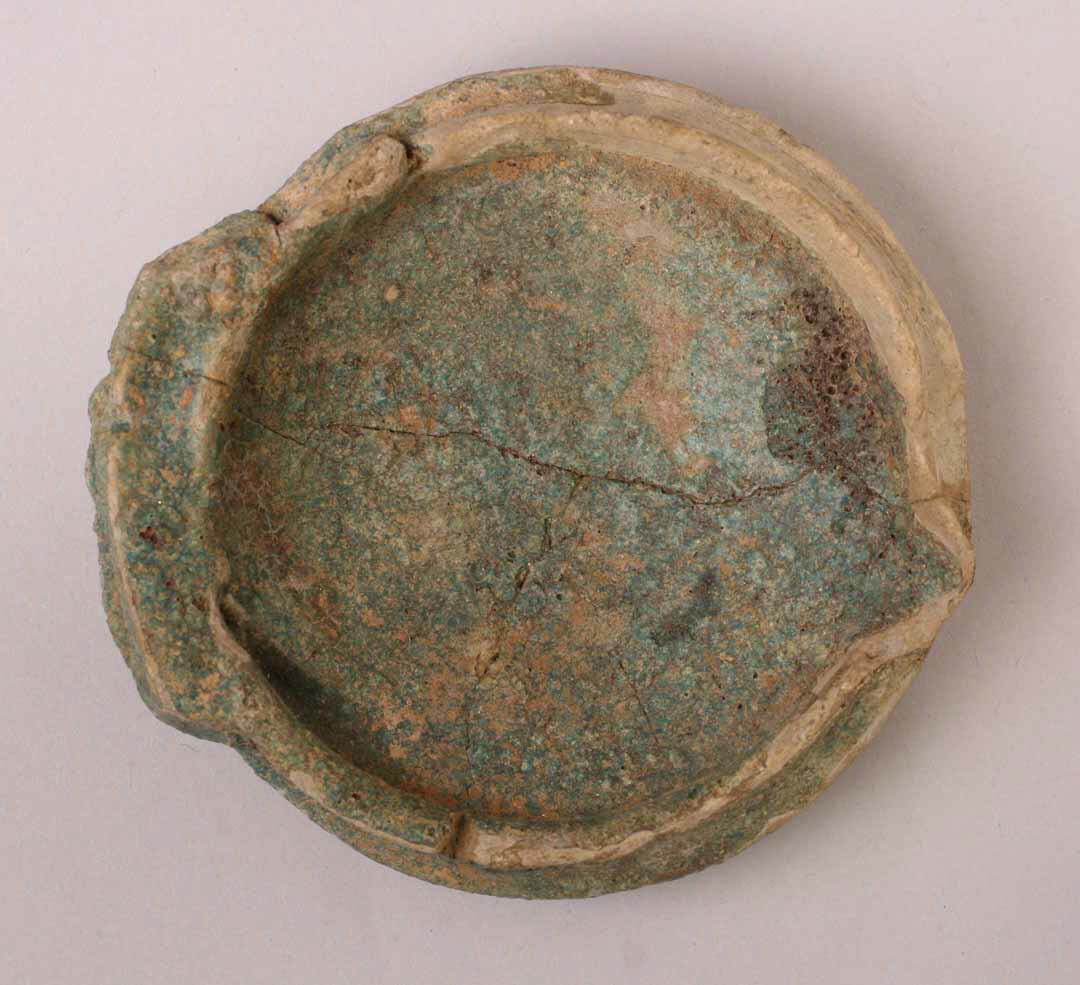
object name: lamp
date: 701-1000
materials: earthenware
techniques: glazing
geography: iraq